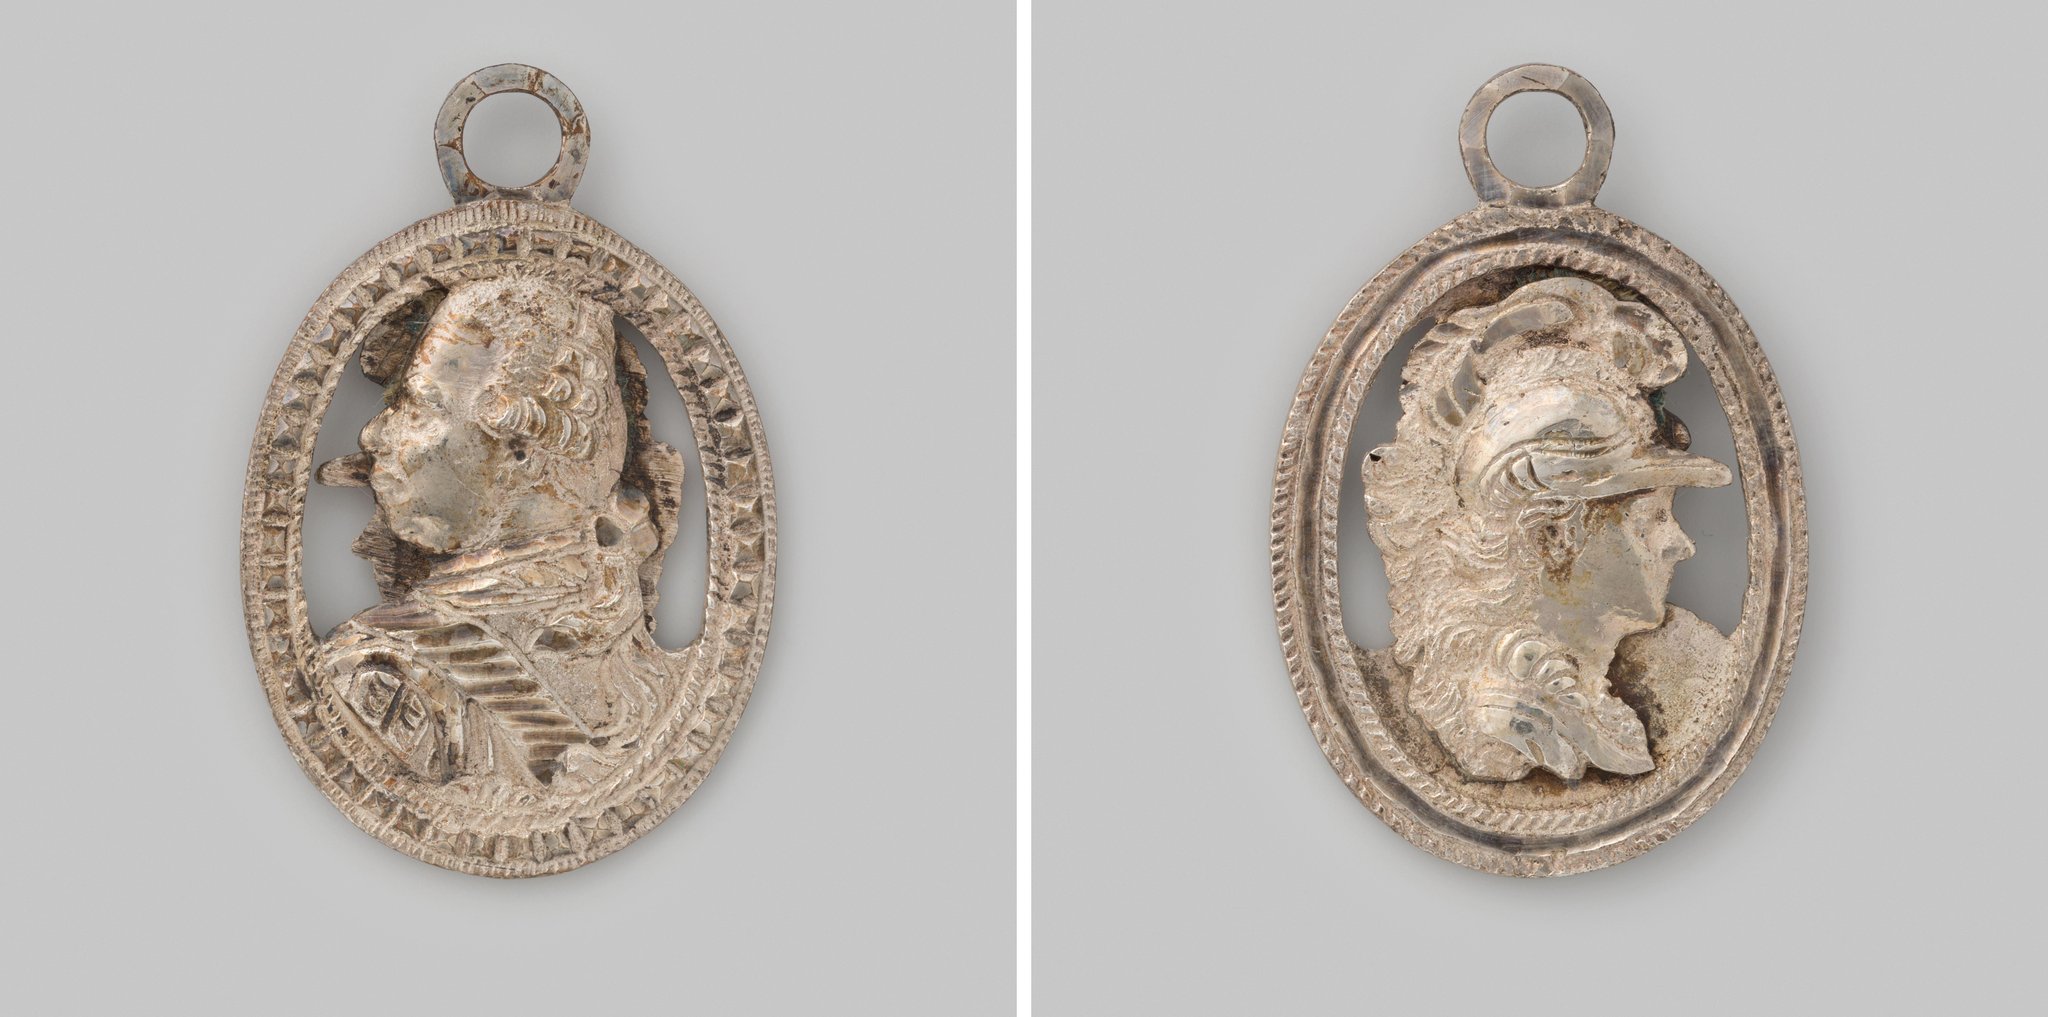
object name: insignia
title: Willem V en Wilhelmina van Pruisen, prins en prinses van Oranje-Nassau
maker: Anonymous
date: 1787-1795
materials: silver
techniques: fastening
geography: netherlands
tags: the hague, william v (prince of orange), painter, draughtsman, wilhelmina of prussia (princess of orange)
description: Zilveren ovale draagteken. Voorzijde: borststuk man binnen gearceerde rand. Keerzijde: borststuk gehelmde vrouw, voorstellende Wilhelmina afgebeeld als Minerva, binnen gearceerde rand